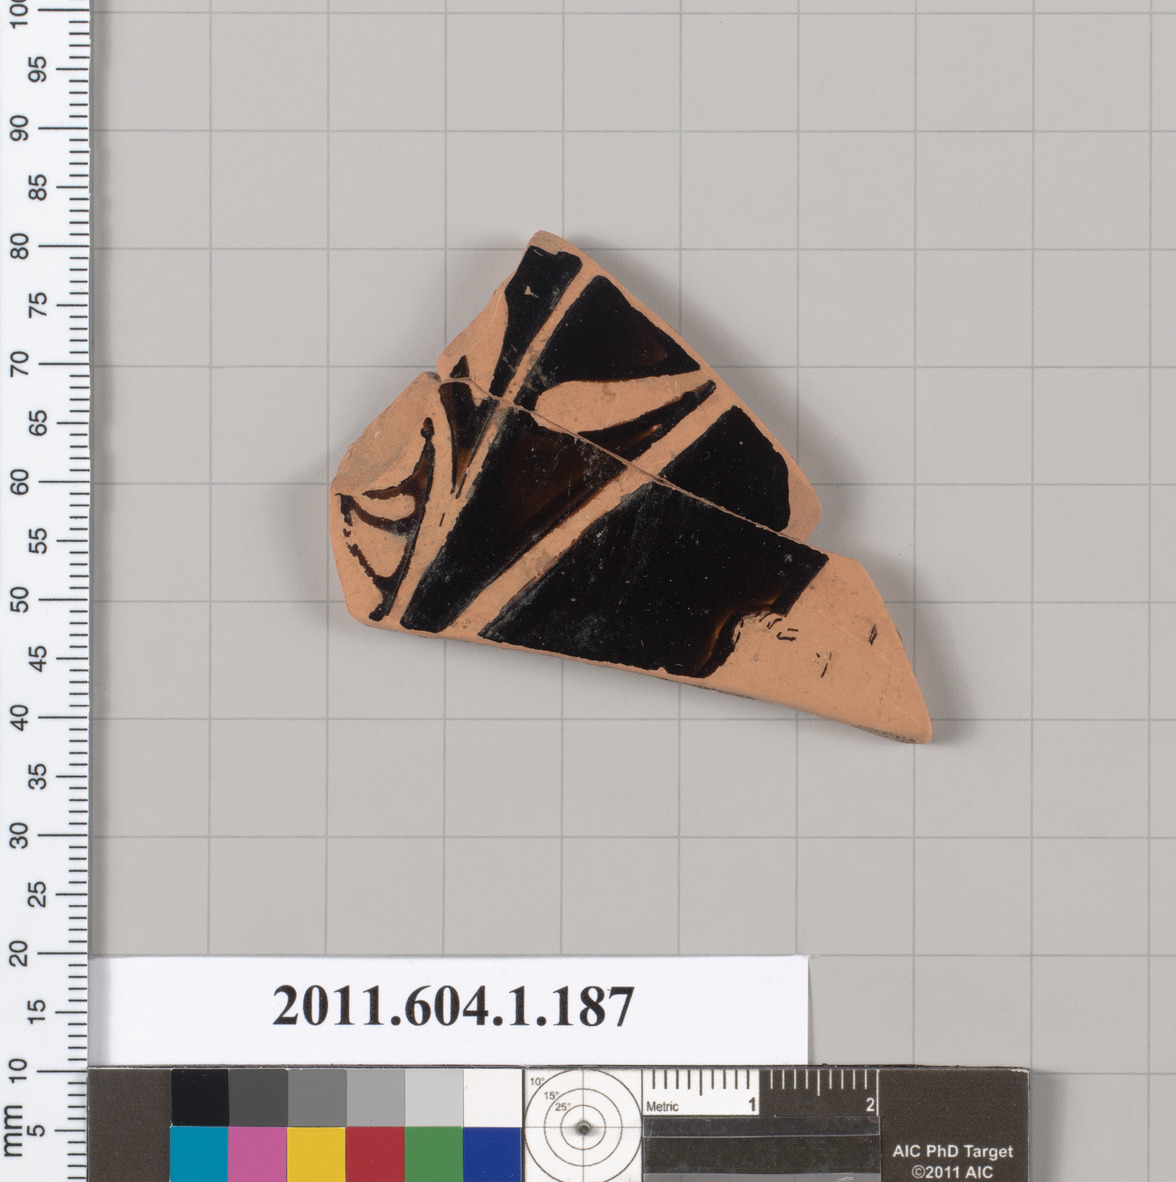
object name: kylix fragment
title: Terracotta fragment of a kylix (drinking cup)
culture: greek, attic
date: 475-451 BCE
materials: terracotta